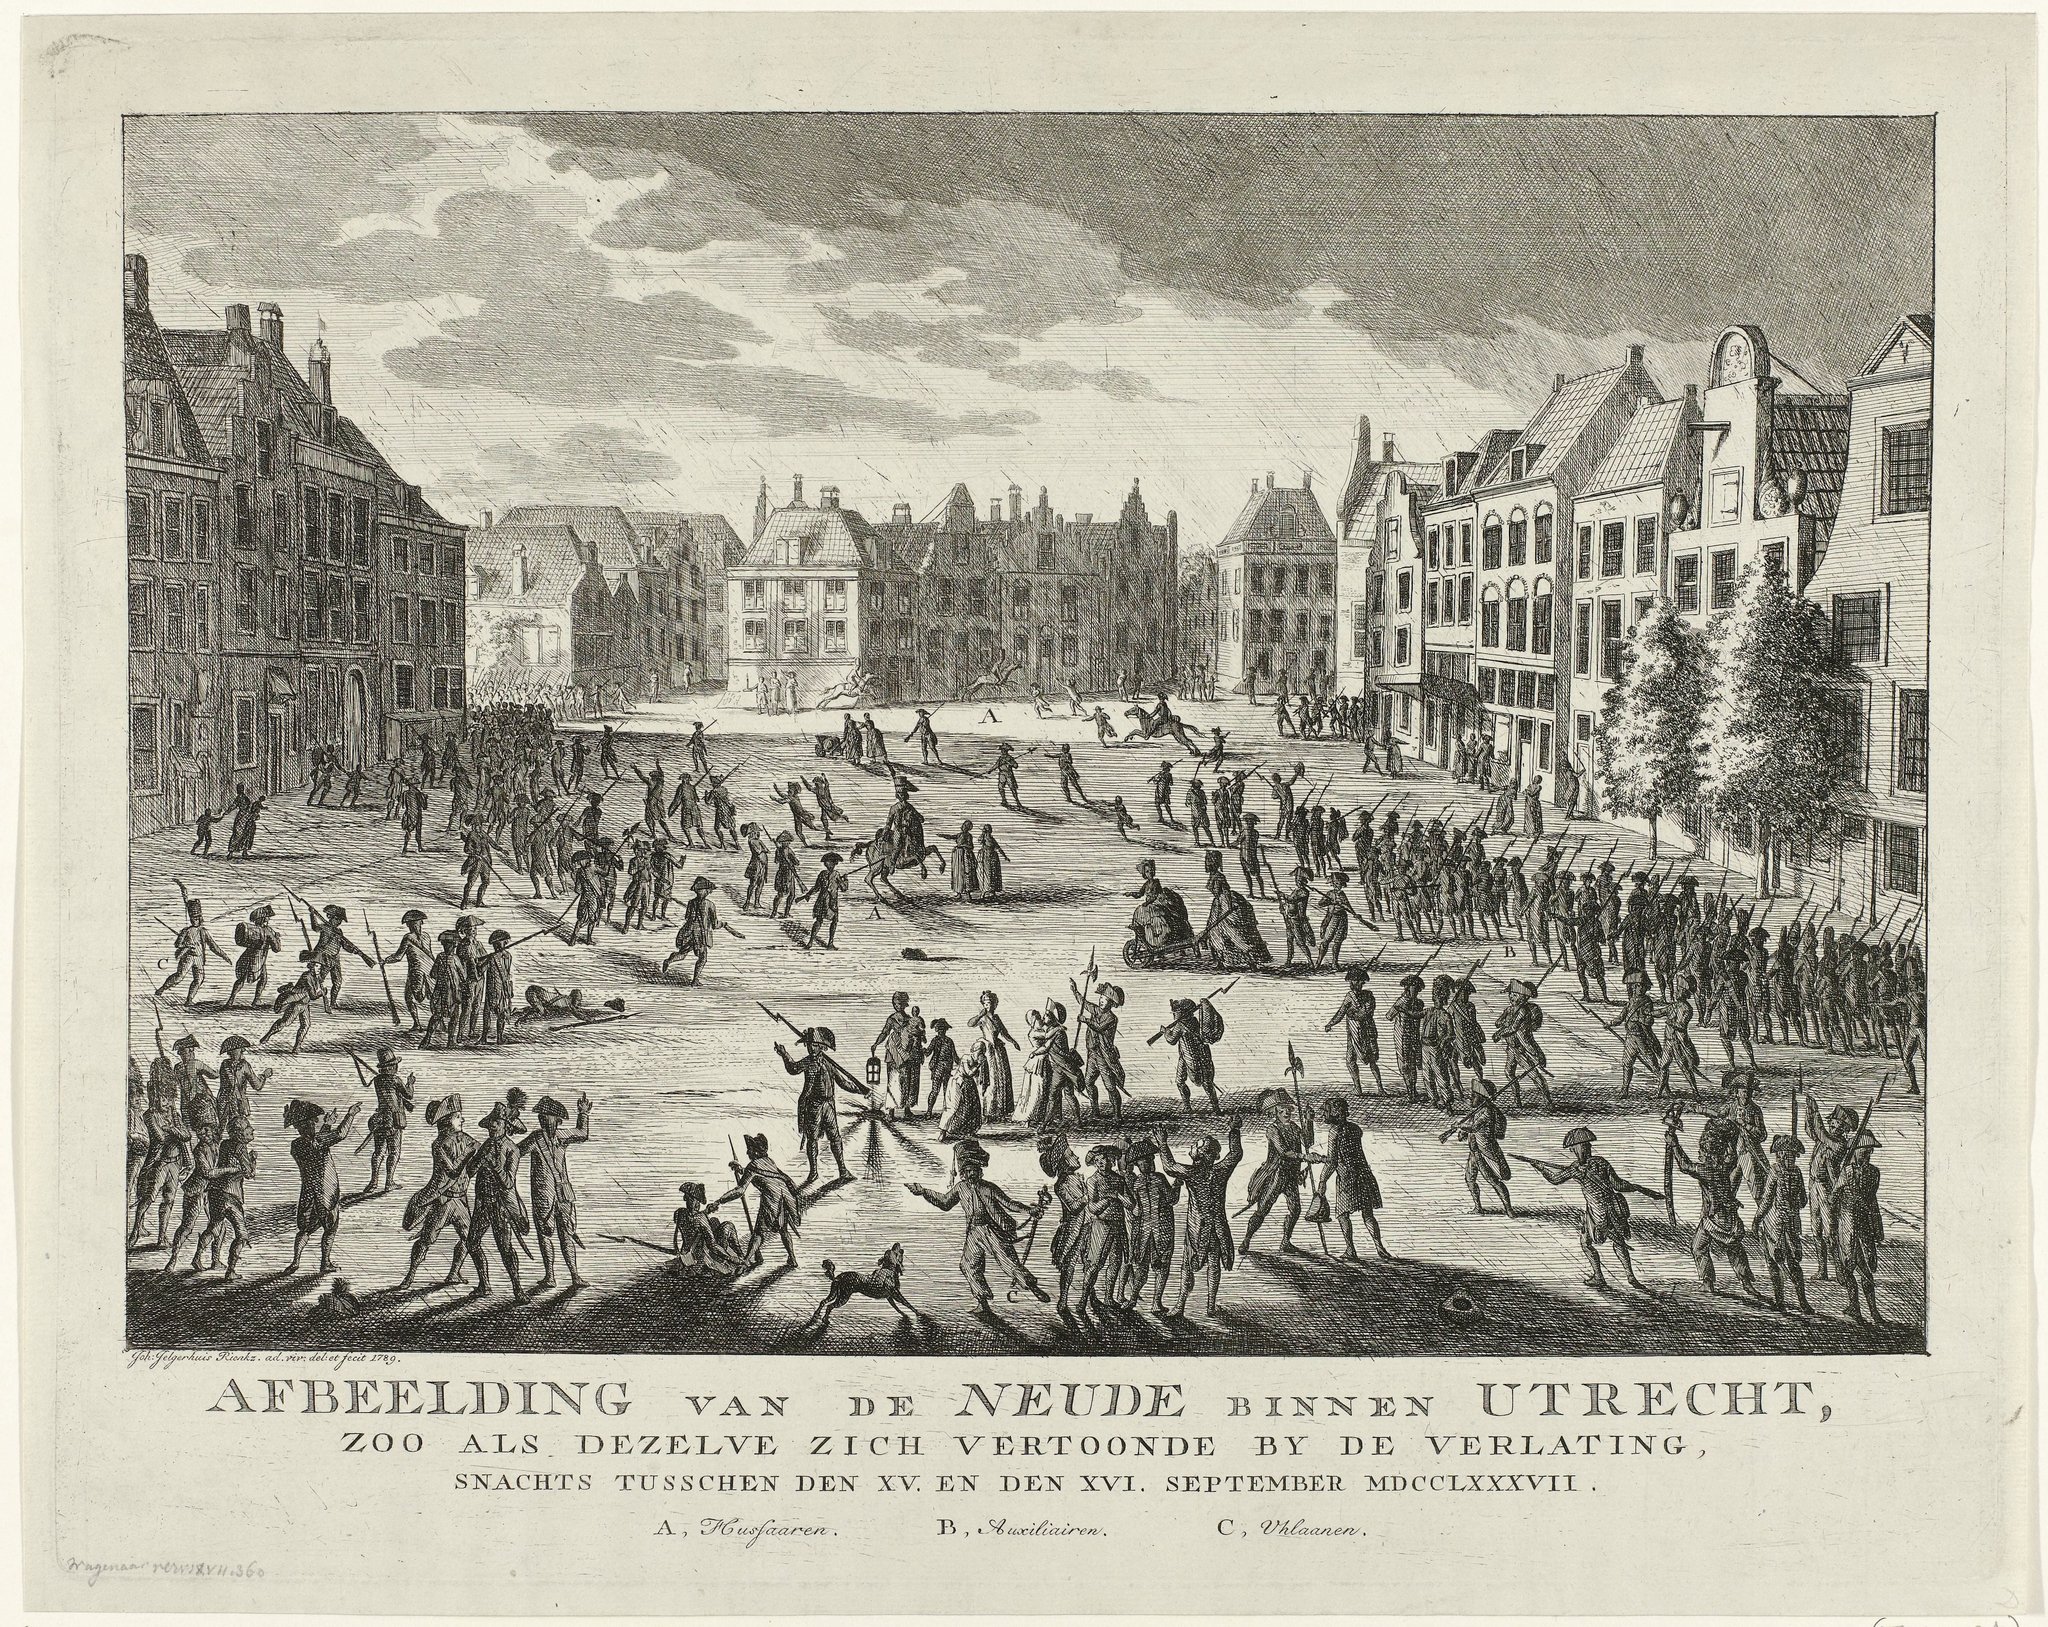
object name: print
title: Patriotten verlaten de Neude te Utrecht, 1787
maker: johannes jelgerhuis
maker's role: draughtsman, painter, print maker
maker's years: 1770-1836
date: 1789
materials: paper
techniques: etching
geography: utrecht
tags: putting the enemy to flight - hh - being put to flight, fleeing (+ citizen soldiery, civil guard, citizen militia)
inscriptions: collector's mark: Lugt 2228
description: Chaos op de Neude te Utrecht in de nacht van 15 op 16 september 1787 als de patriotse schutterijen het plein en de stad ontvluchten wegens de naderende Pruisische troepen. Zie de pendant.